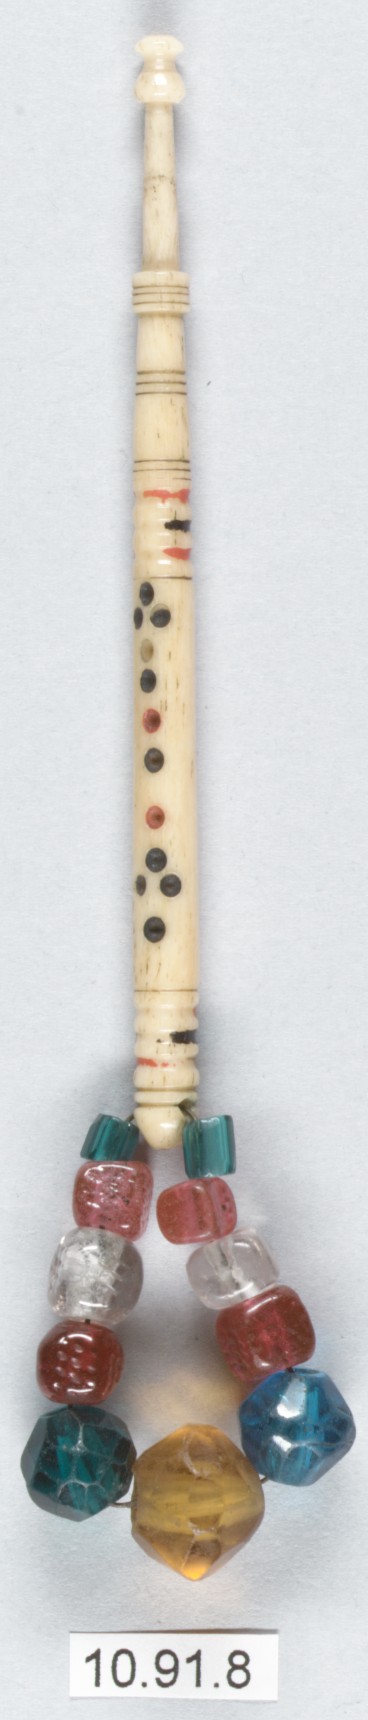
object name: bobbin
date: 1801-1900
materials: bone